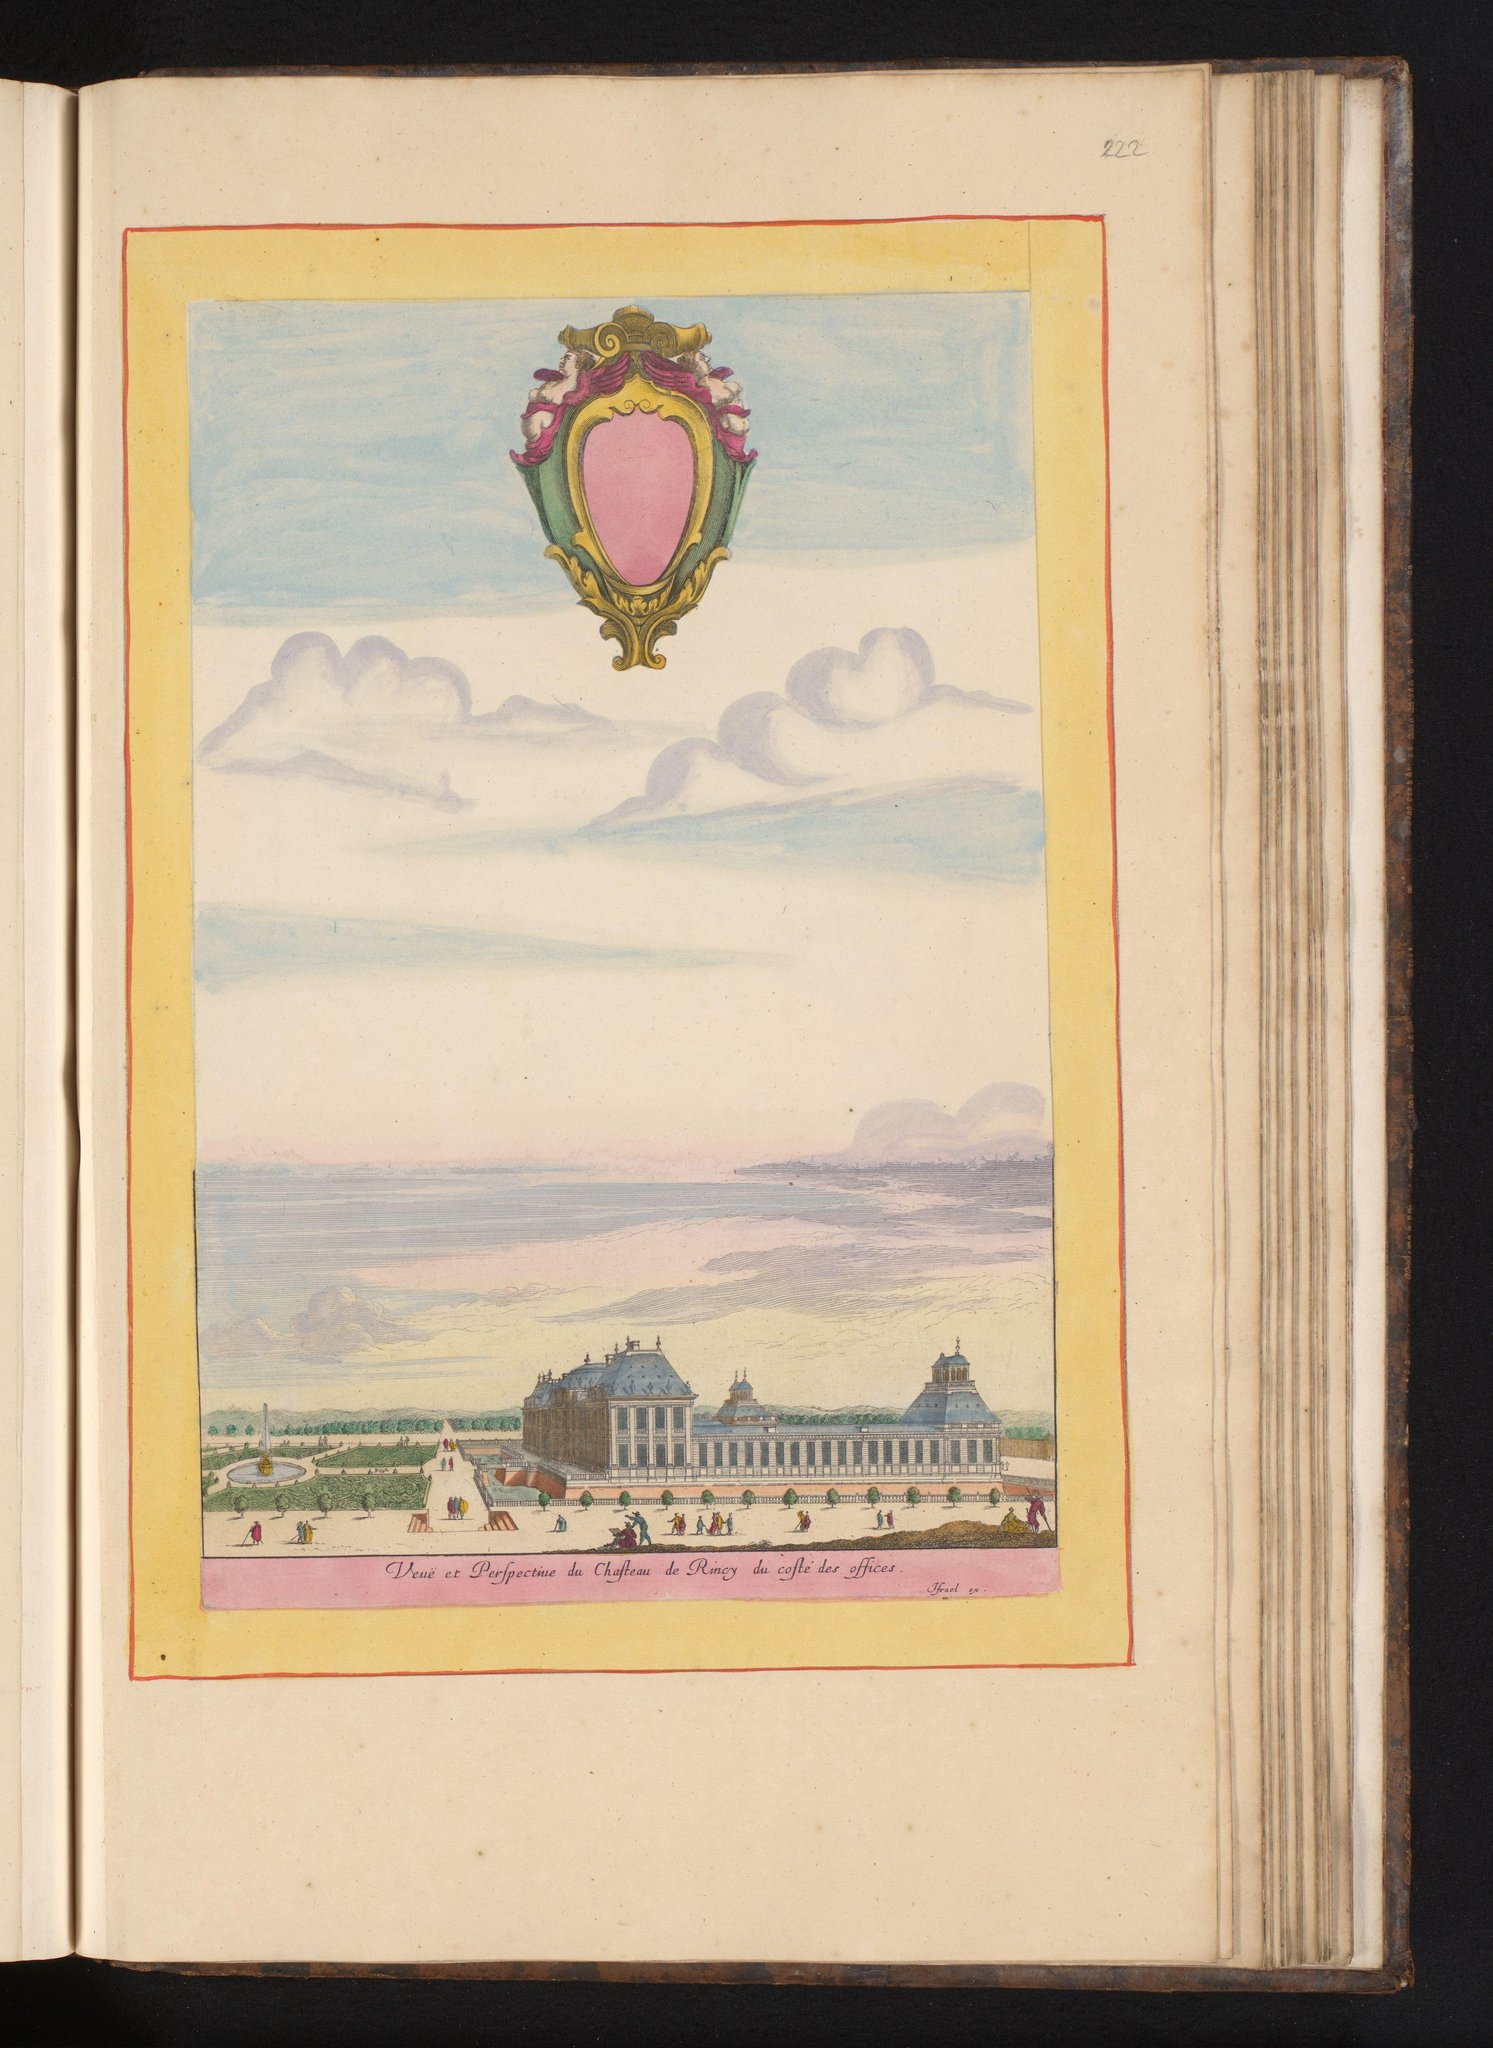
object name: album leaf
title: Veuë et Perspective du Chasteau de Rincy du costé des offices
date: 1631-1661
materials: paper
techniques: etching, hand coloring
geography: paris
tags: castle, french or architectonic garden; formal garden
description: Gezicht op de kantoren van Château du Raincy. In de lucht een ornamenteel leeg wapenschild. Prent maakt deel uit van een album.